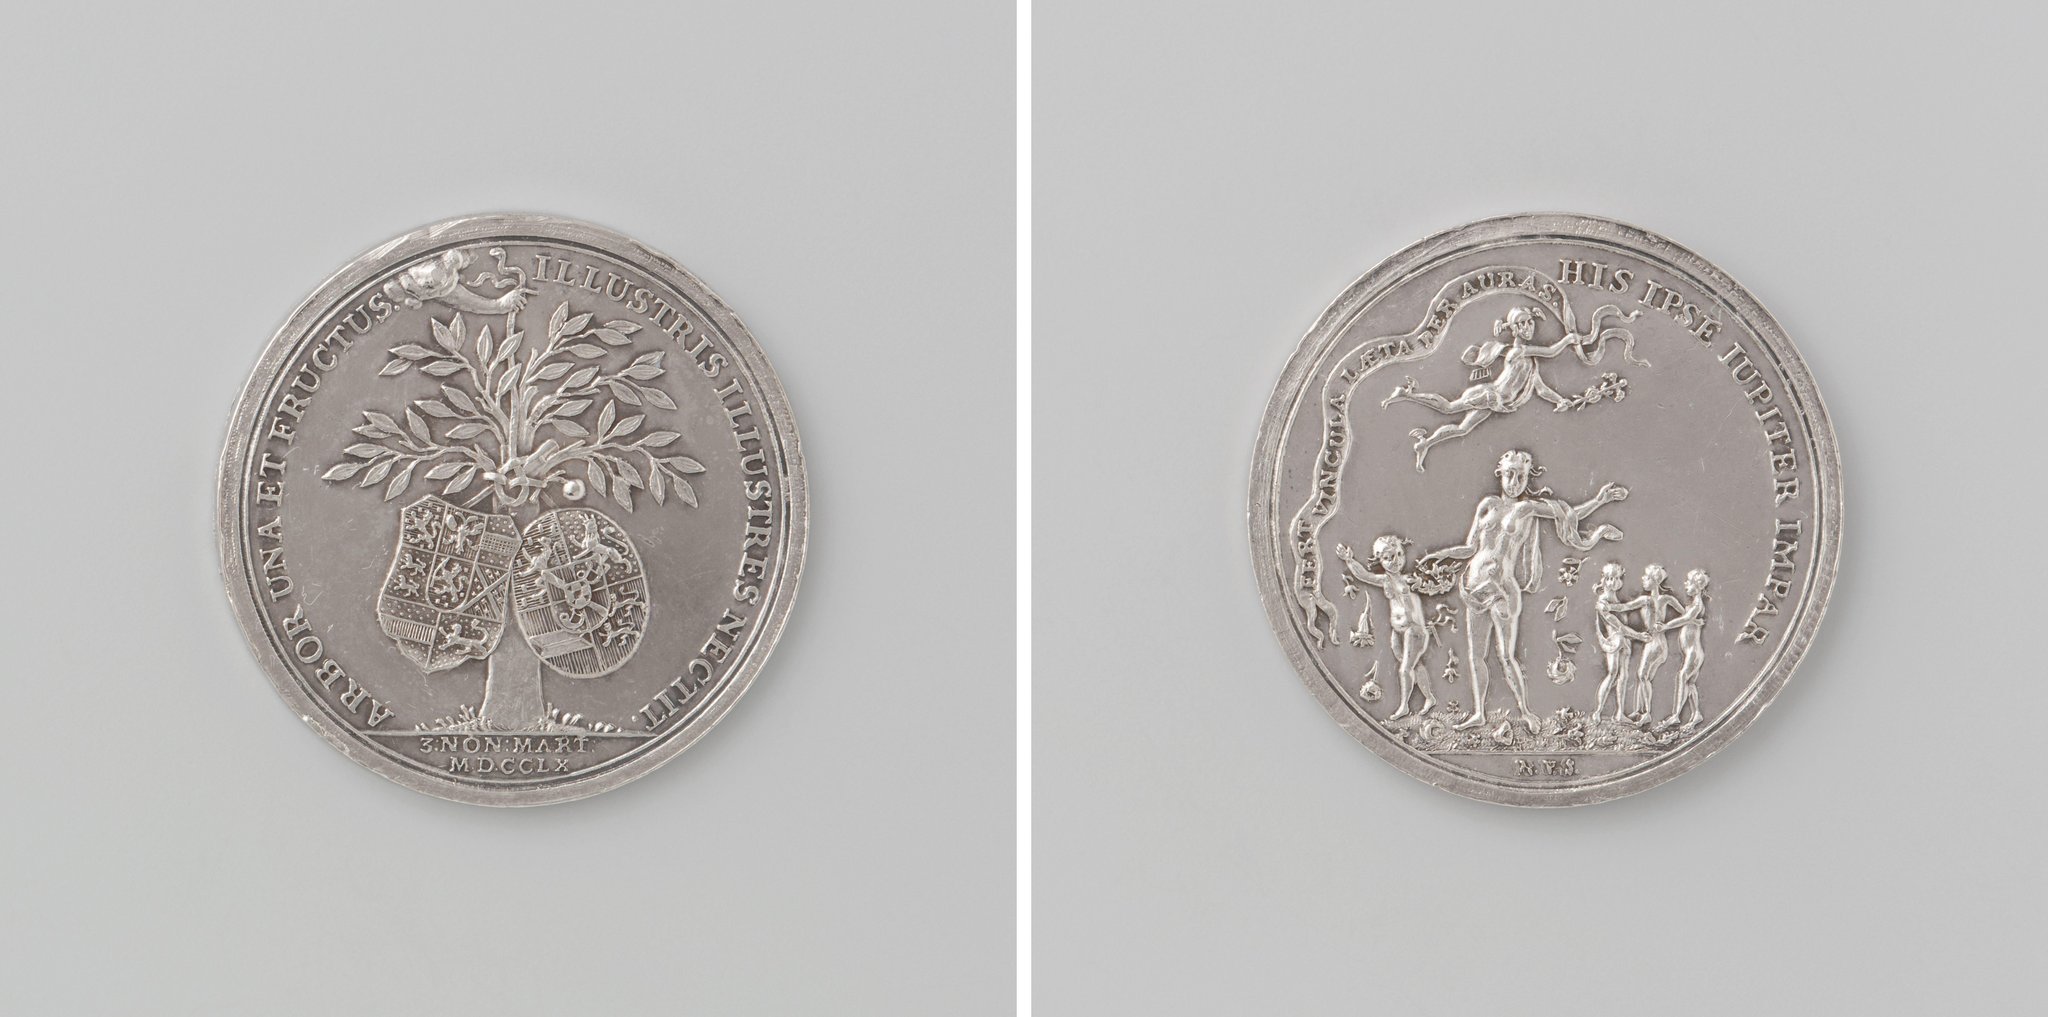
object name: history medal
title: Huwelijk van Karel Christiaan van Nassau-Weilburg en Carolina, prinses van Oranje-Nassau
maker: nicolaas van swinderen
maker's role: jeweler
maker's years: 1705-1760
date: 1760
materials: silver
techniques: striking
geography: amsterdam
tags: carolina (prinses van oranje-nassau), karel christiaan vorst van nassau-weilburg, the hague